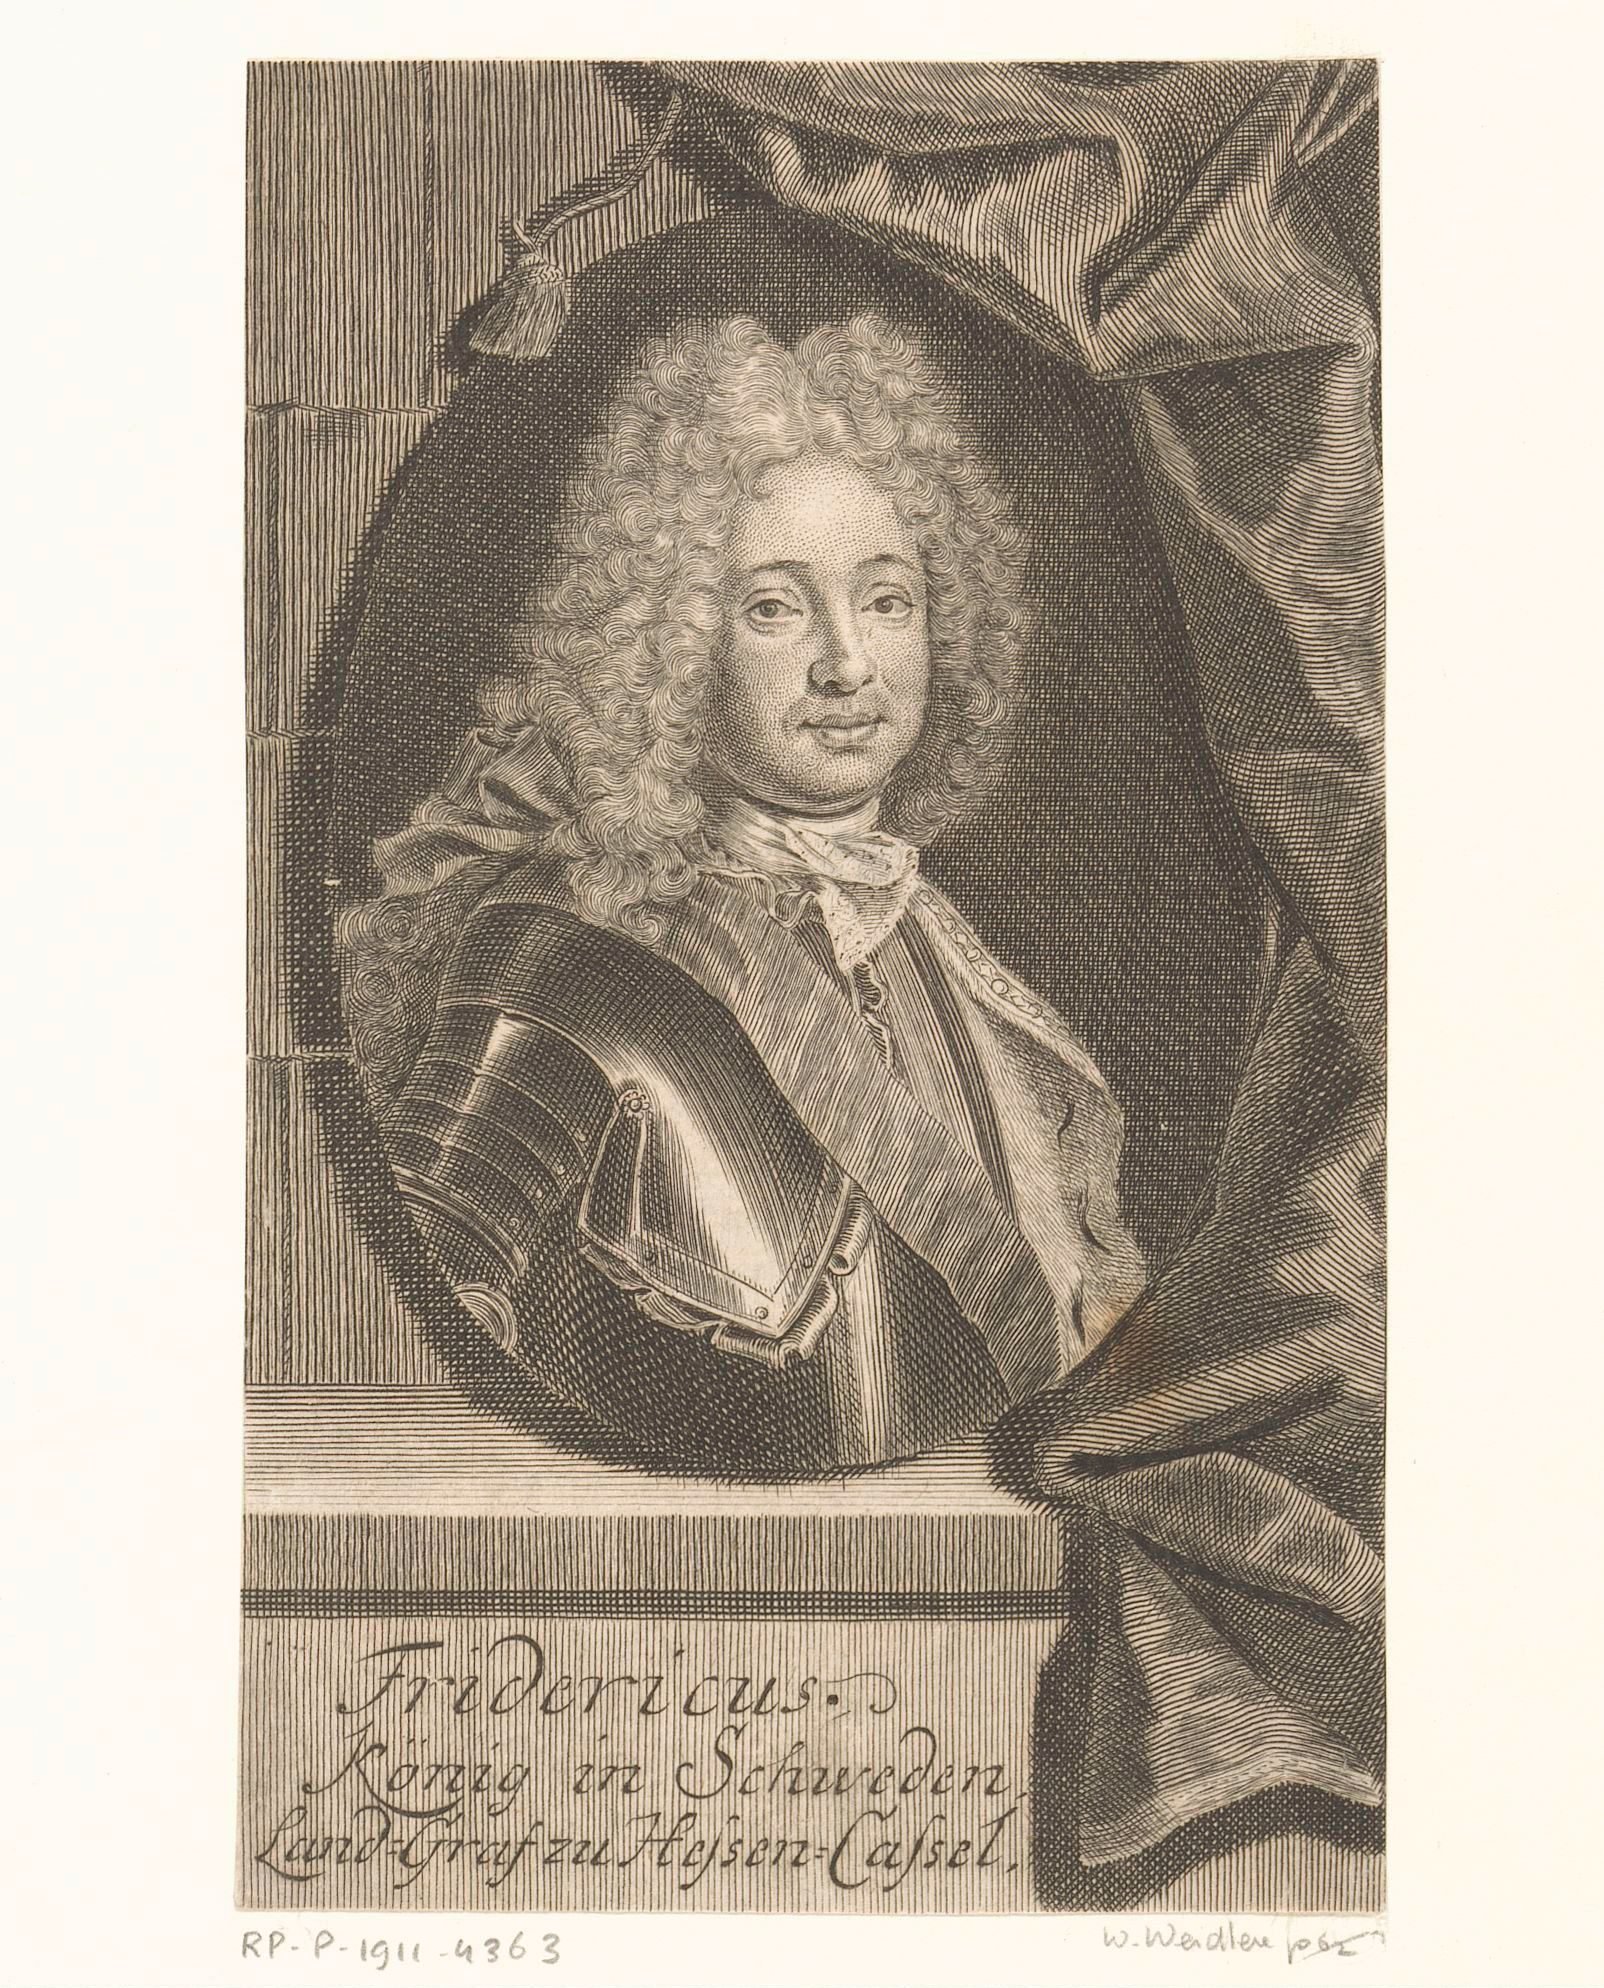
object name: print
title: Portret van Friedrich von Hessen-Kassel, koning van Zweden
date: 1720-1751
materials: paper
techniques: engraving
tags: frederik i (koning van zweden), armour, historical persons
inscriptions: collector's mark: Lugt 2228